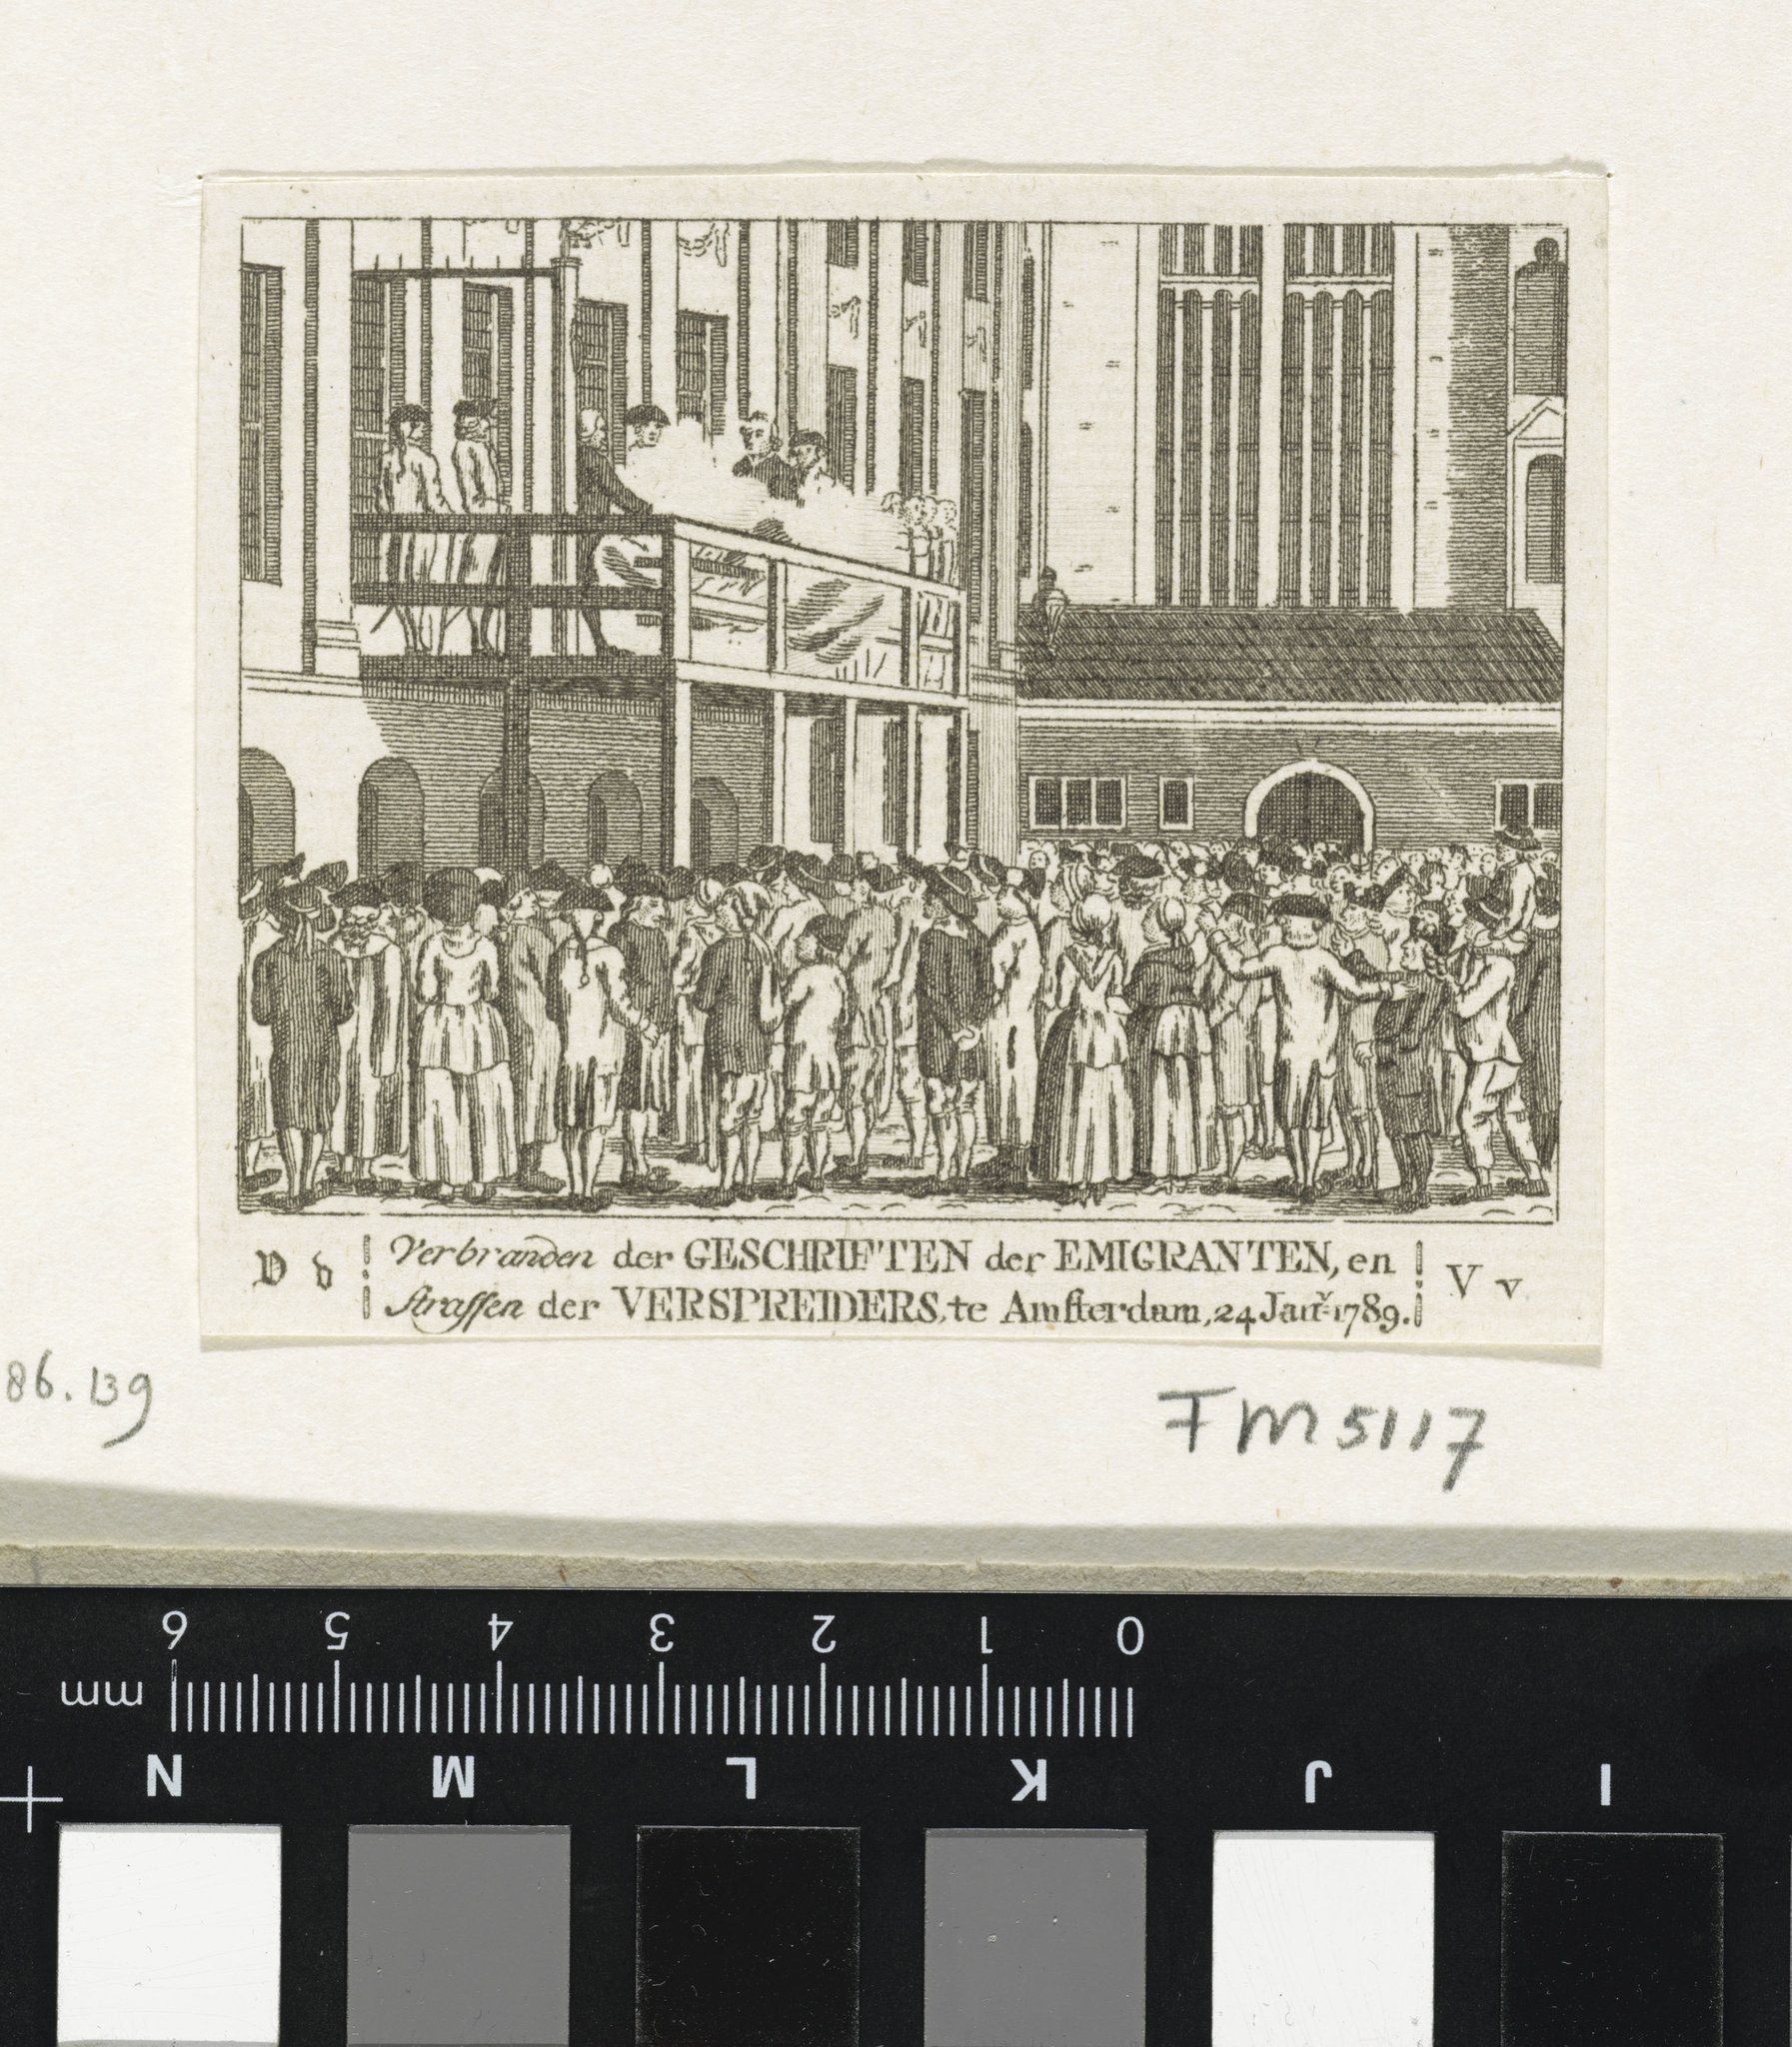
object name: print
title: Verbranden van pamfletten te Amsterdam, 1789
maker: Anonymous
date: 1789-1790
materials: paper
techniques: etching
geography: northern netherlands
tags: burning of books, patriots (1780-1795)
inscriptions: collector's mark: Lugt 2228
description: Het in de vorm van een executie verbranden van pamfletten van uitgeweken patriotten op een schavot voor het stadhuis op de Dam te Amsterdam, 24 januari 1789. Tegelijkertijd werd de verspreider van de pamfletten in het openbaar gegeseld. Plaatje behorend bij de letter V uit een ABC boek. Bij de prent behoort een tekstblad met uitleg.